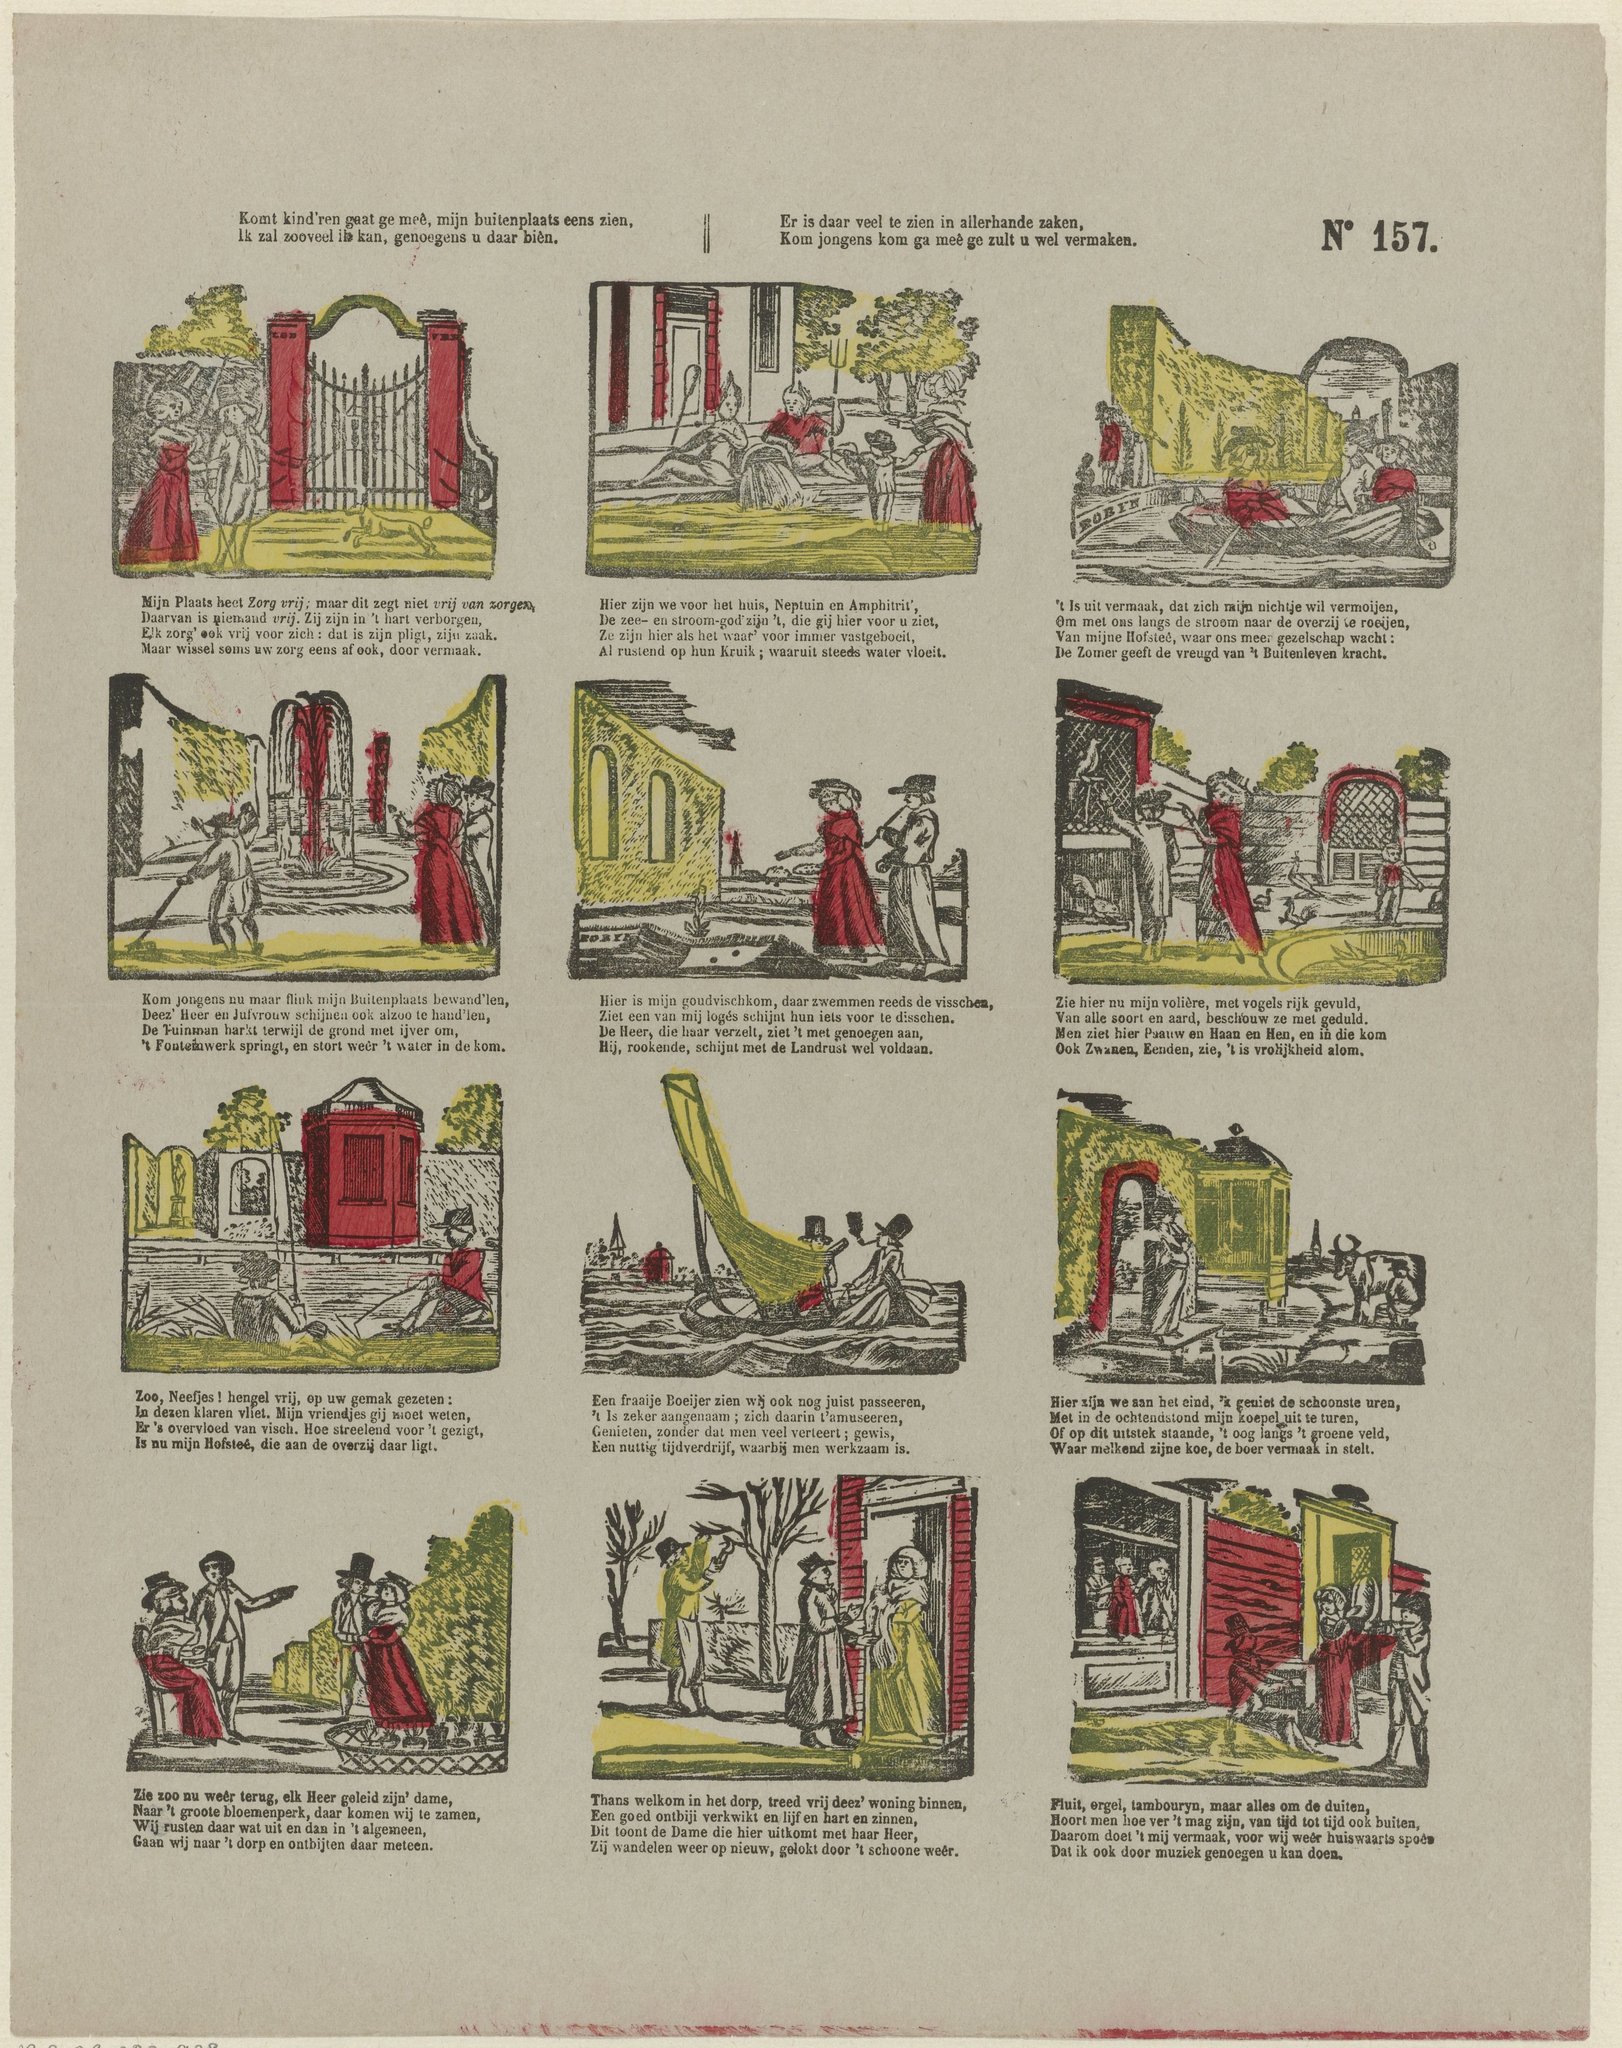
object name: popular print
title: Komt kind'ren gaat ge meê, mijn buitenplaats eens zien, / Ik zal zooveel ik kan, genoegens u daar biên / Er is daar veel te zien in allerhande zaken, / Kom jongens kom ga meê ge zult u wel vermaken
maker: m. hemeleers-van houter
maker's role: printer, publisher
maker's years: -1880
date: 1827-1894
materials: paper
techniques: colour, letterpress printing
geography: schaarbeek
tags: walking, hiking (recreation), garden, garden fountain, fishing (sports)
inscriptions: collector's mark: Lugt 2760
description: Blad met 12 voorstellingen van mensen in tuinen, parken, bij fonteinen en op het water. Onder elke afbeelding een vierregelig vers. Genummerd rechtsboven: No 157.